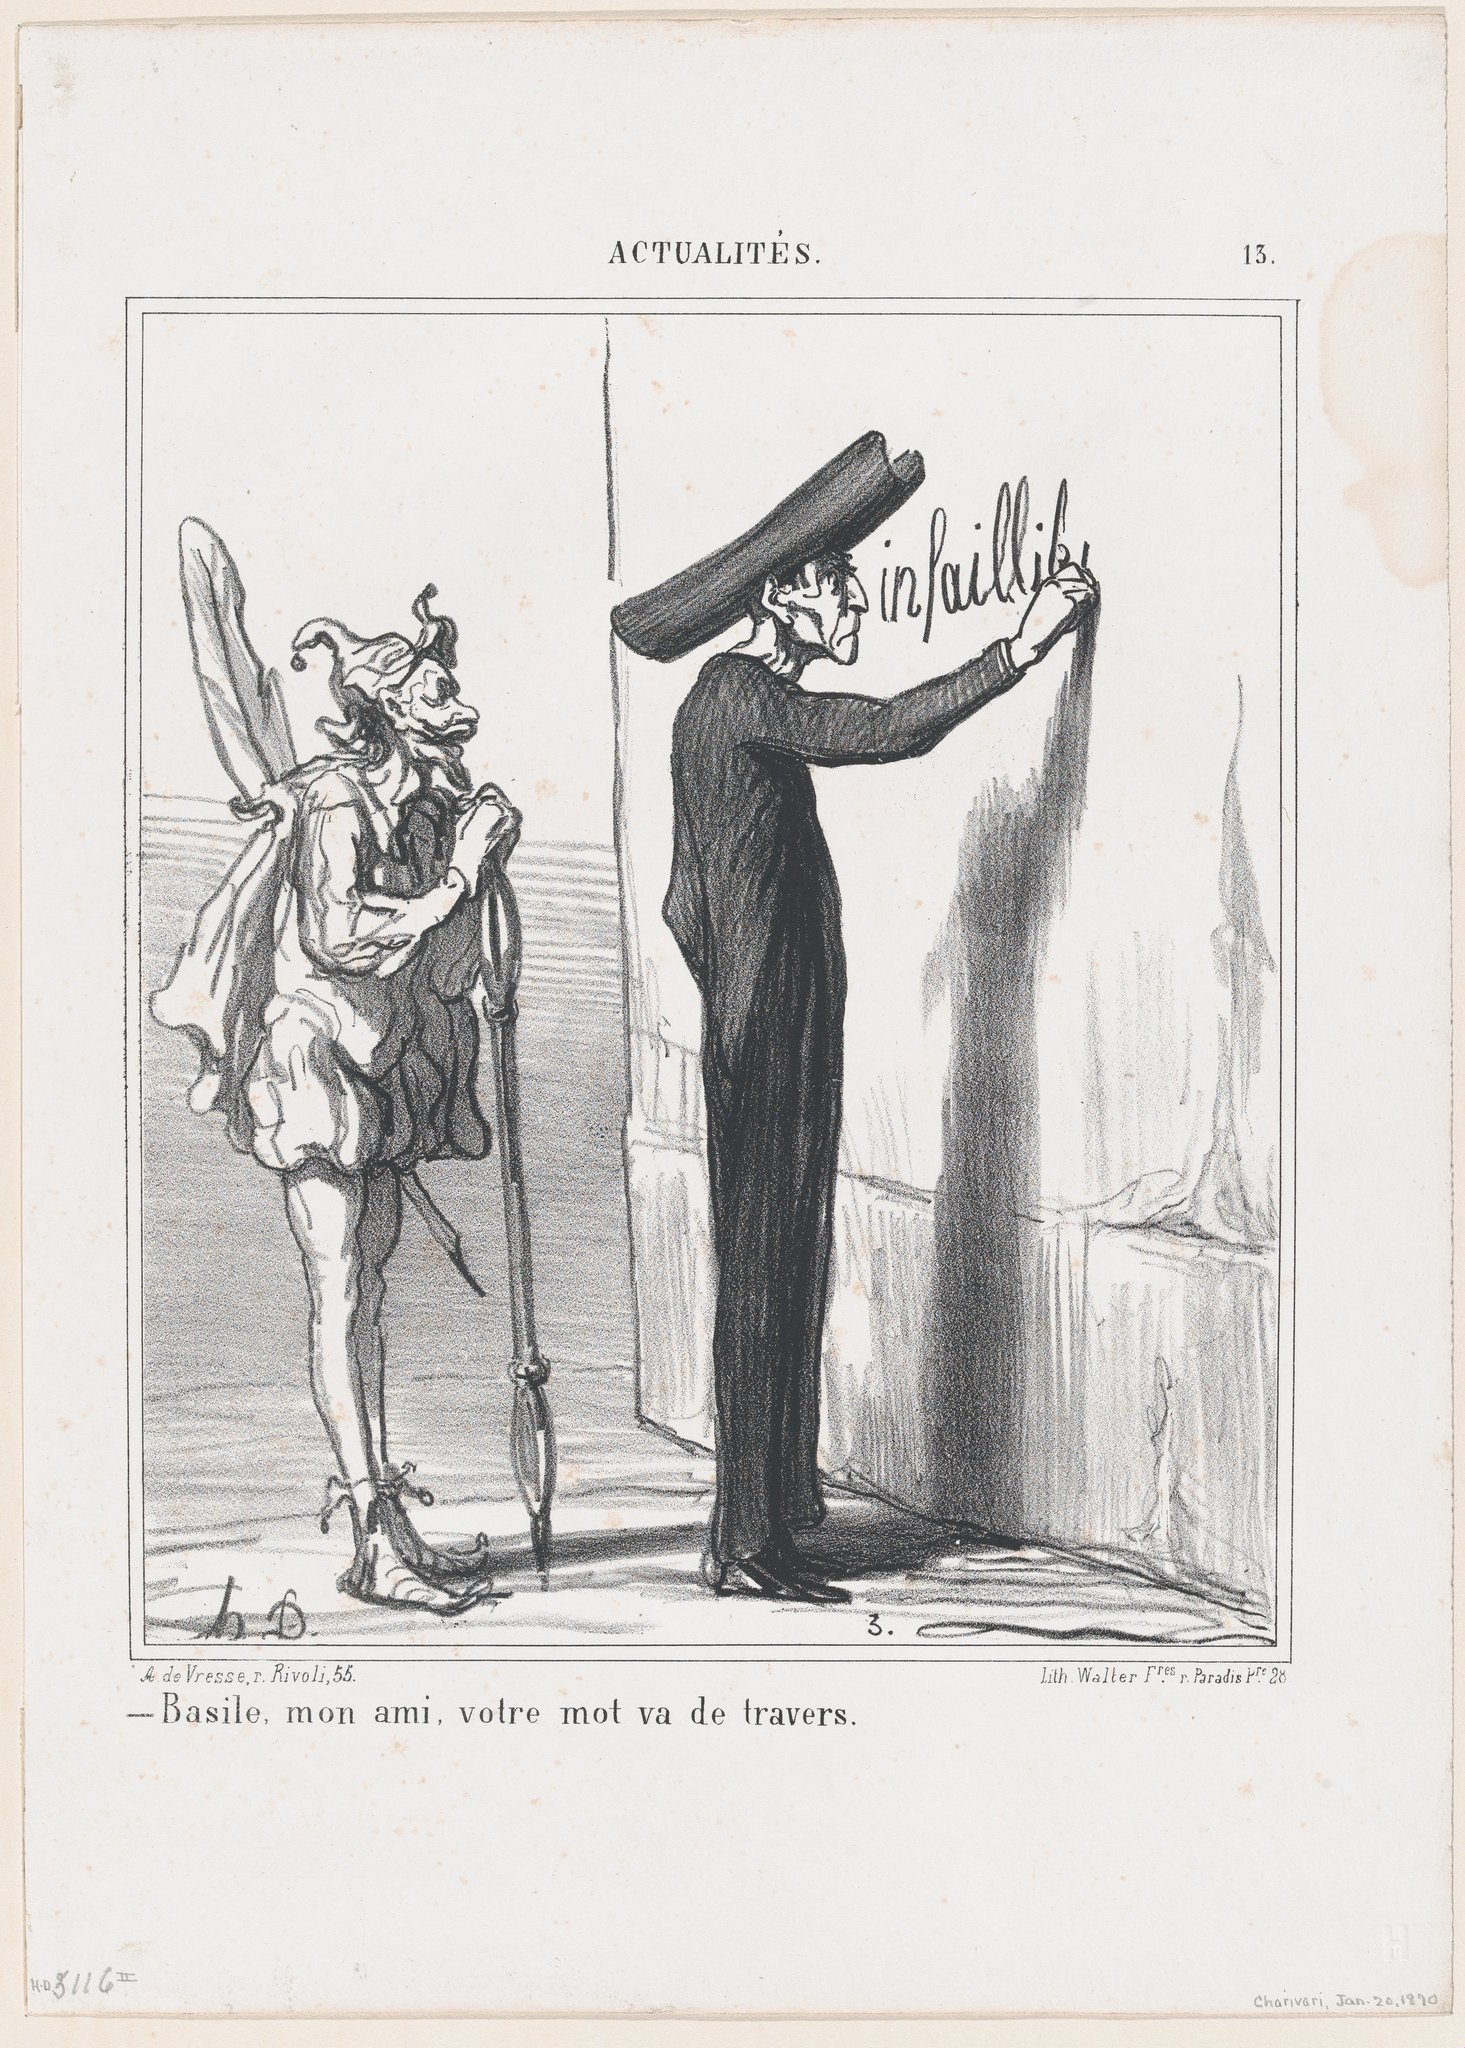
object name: print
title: Basile, my friend, your word is going to be askew, from 'News of the day,' published in Le Charivari, January 20, 1870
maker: honoré daumier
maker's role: artist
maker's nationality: french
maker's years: 1808-1879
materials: paper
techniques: lithograph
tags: satire,men,writing